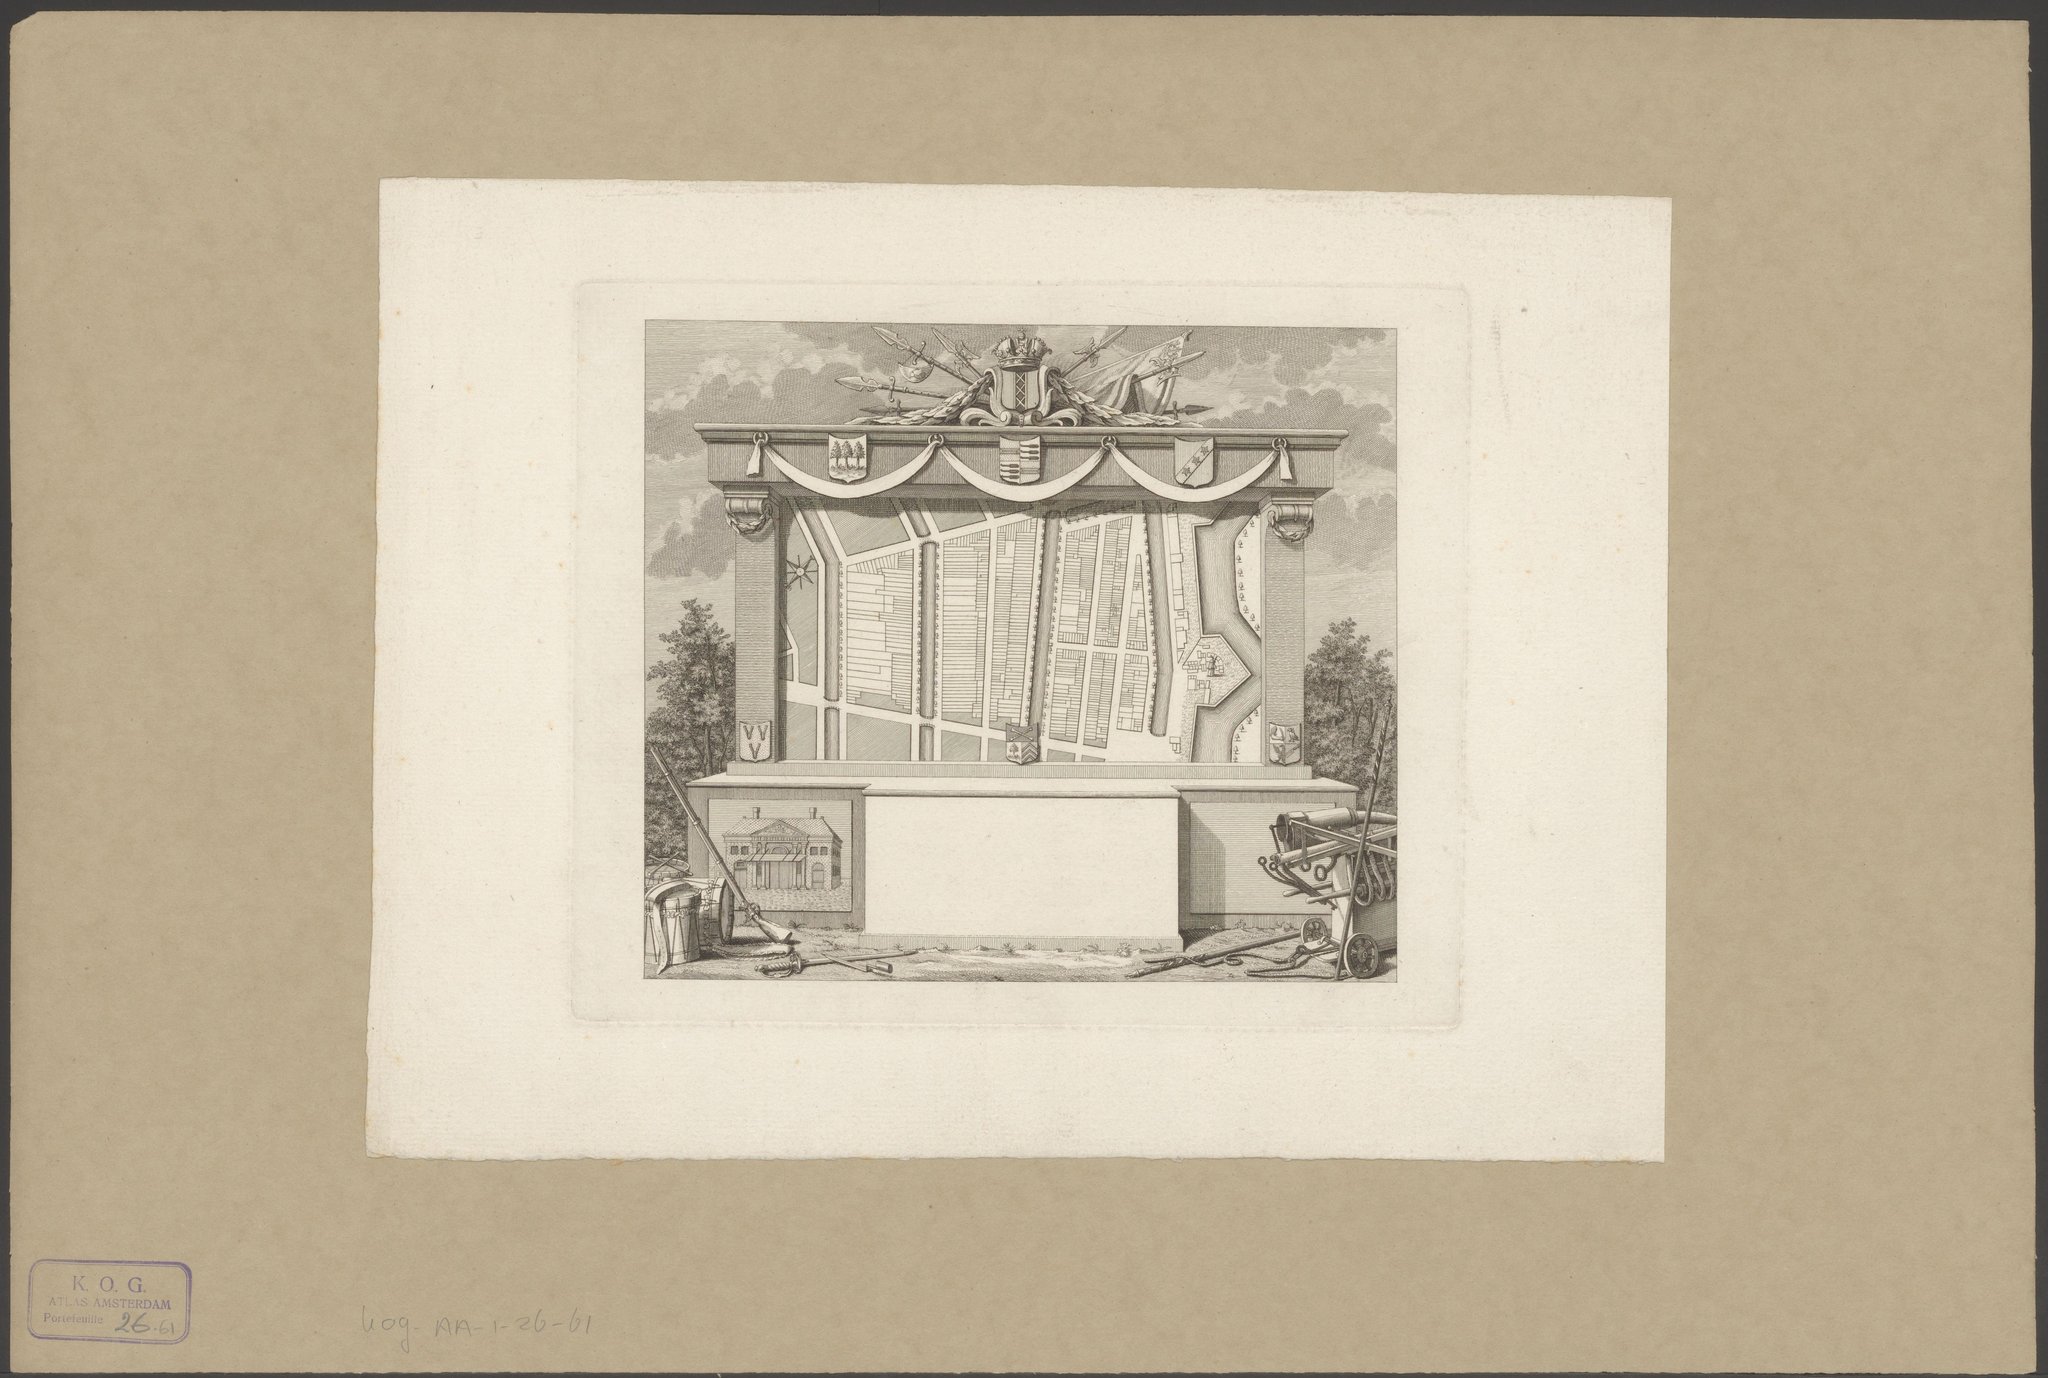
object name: area plan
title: Schuttersbrief van kapitein Jan Bernd Bicker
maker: theodoor koning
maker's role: print maker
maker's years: 1748-1829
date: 1779-1787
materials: paper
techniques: etching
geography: amsterdam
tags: coat of arms (as symbol of the state, etc.) (+ city; municipal), firearms, armorial bearing, heraldry, amsterdam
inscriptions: collector's mark: Lugt 1641b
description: Onderwerpsrubriek binnen de Atlas Amsterdam: Schutters-oproepingsbriefjes.